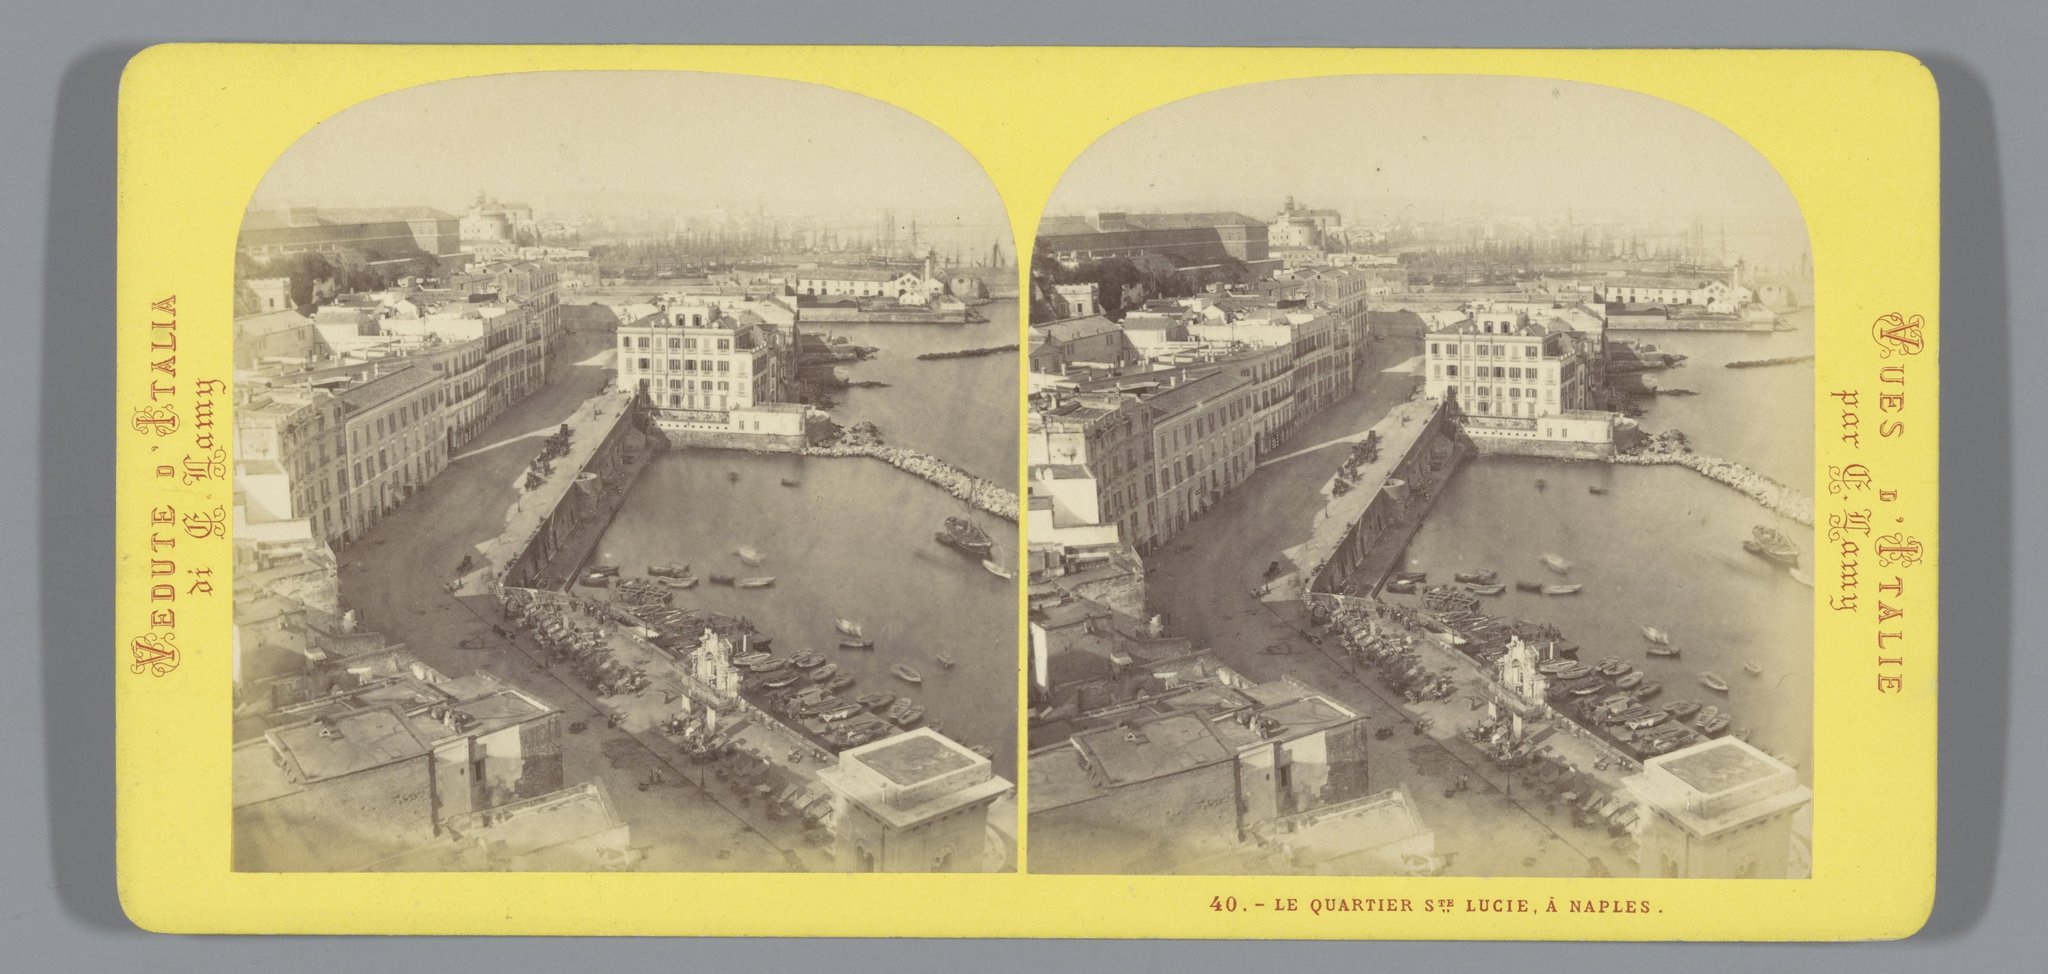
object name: stereograph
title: Gezicht op Borgo Santa Lucia in Napels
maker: ernest eléonor pierre lamy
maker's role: publisher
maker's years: 1828-1900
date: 1861-1878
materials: cardboard, paper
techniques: albumen print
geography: naples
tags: harbour, city-view in general; 'veduta'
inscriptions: number: ‘40.’